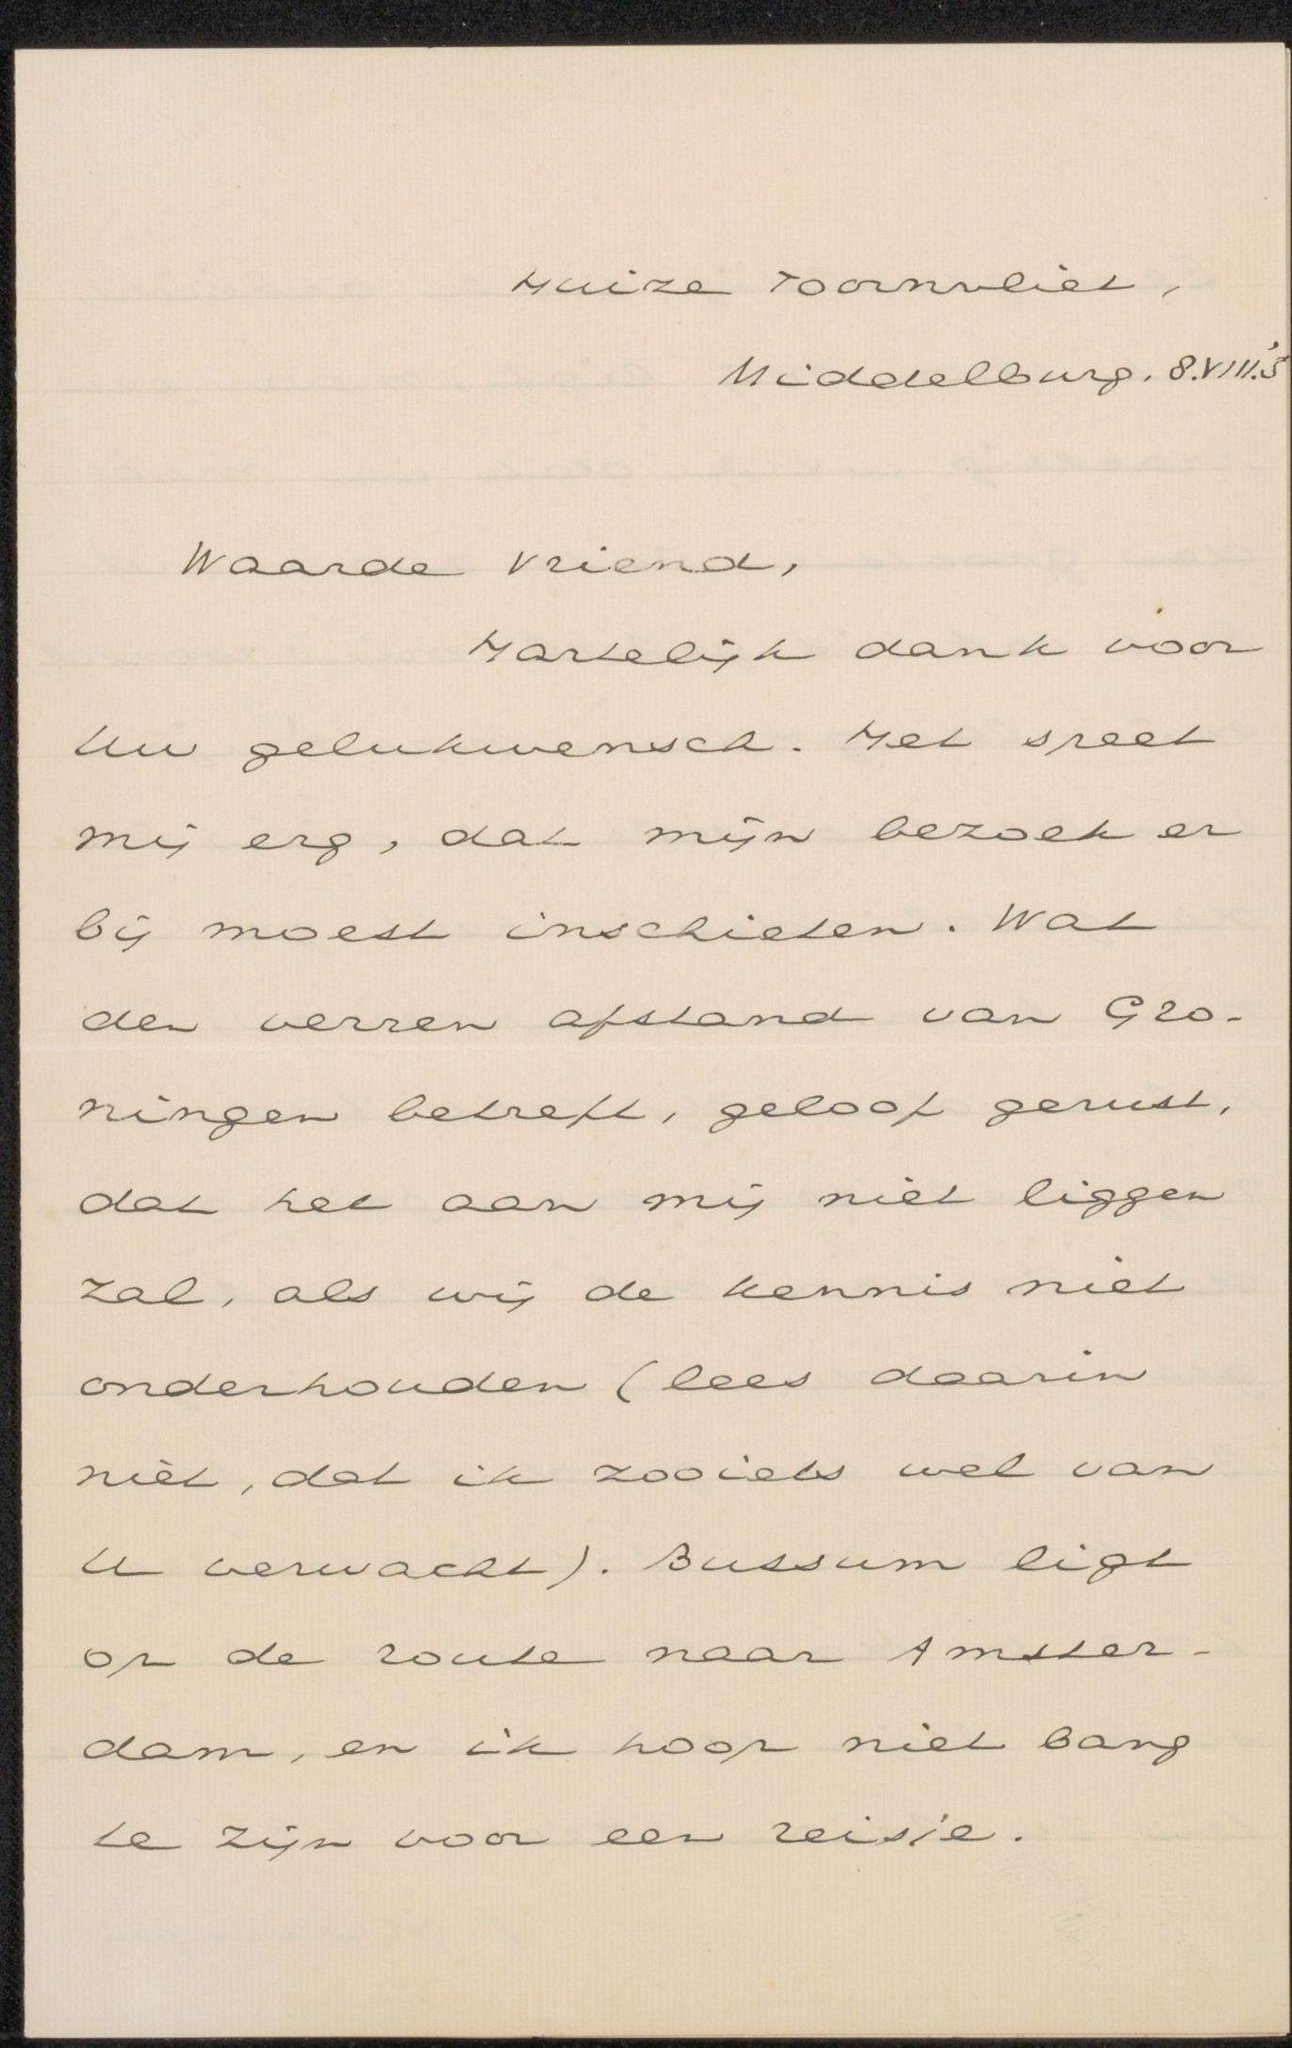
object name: letter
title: Brief aan Jan Veth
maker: johan huizinga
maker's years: 1872-1945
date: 1905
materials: ink, paper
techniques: pen, writing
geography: middelburg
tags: dordrecht, amsterdam, painter, print maker, draughtsman, designer, jan veth, andré jolles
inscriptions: watermark, collector's mark: ‘RPK’